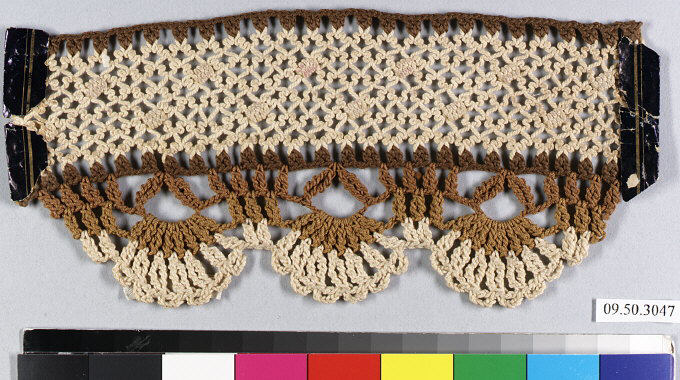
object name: sample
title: Crochet Work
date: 1801-1900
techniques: crochet